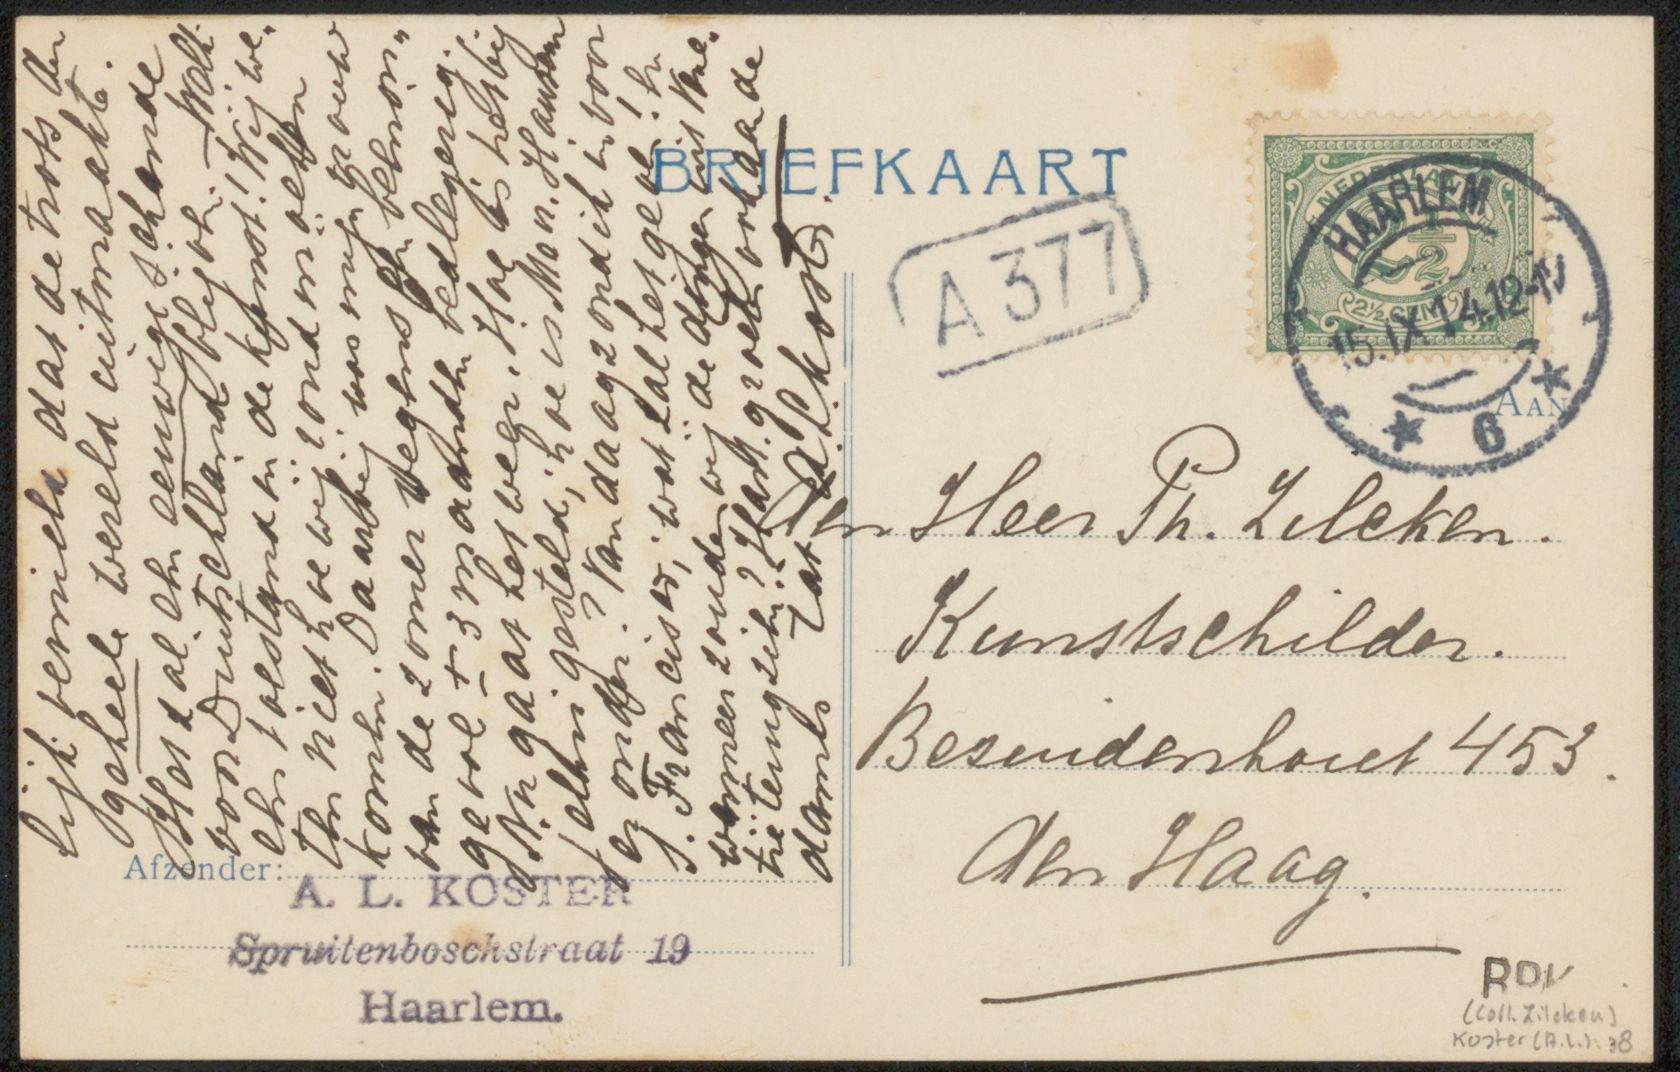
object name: postcard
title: Briefkaart aan Philip Zilcken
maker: anton l. koster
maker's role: draughtsman, painter, print maker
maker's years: 1859-1937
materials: cardboard, ink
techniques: pen, writing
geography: haarlem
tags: rotterdam, johan hendrik van mastenbroek, painter, draughtsman, philip zilcken, family life, painting (including book-illumination, miniature-painting), venice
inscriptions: collector's mark: ‘RPK’, address: ‘A.L. KOSTER/ Spruitenboschstraat 19/ Haarlem.’